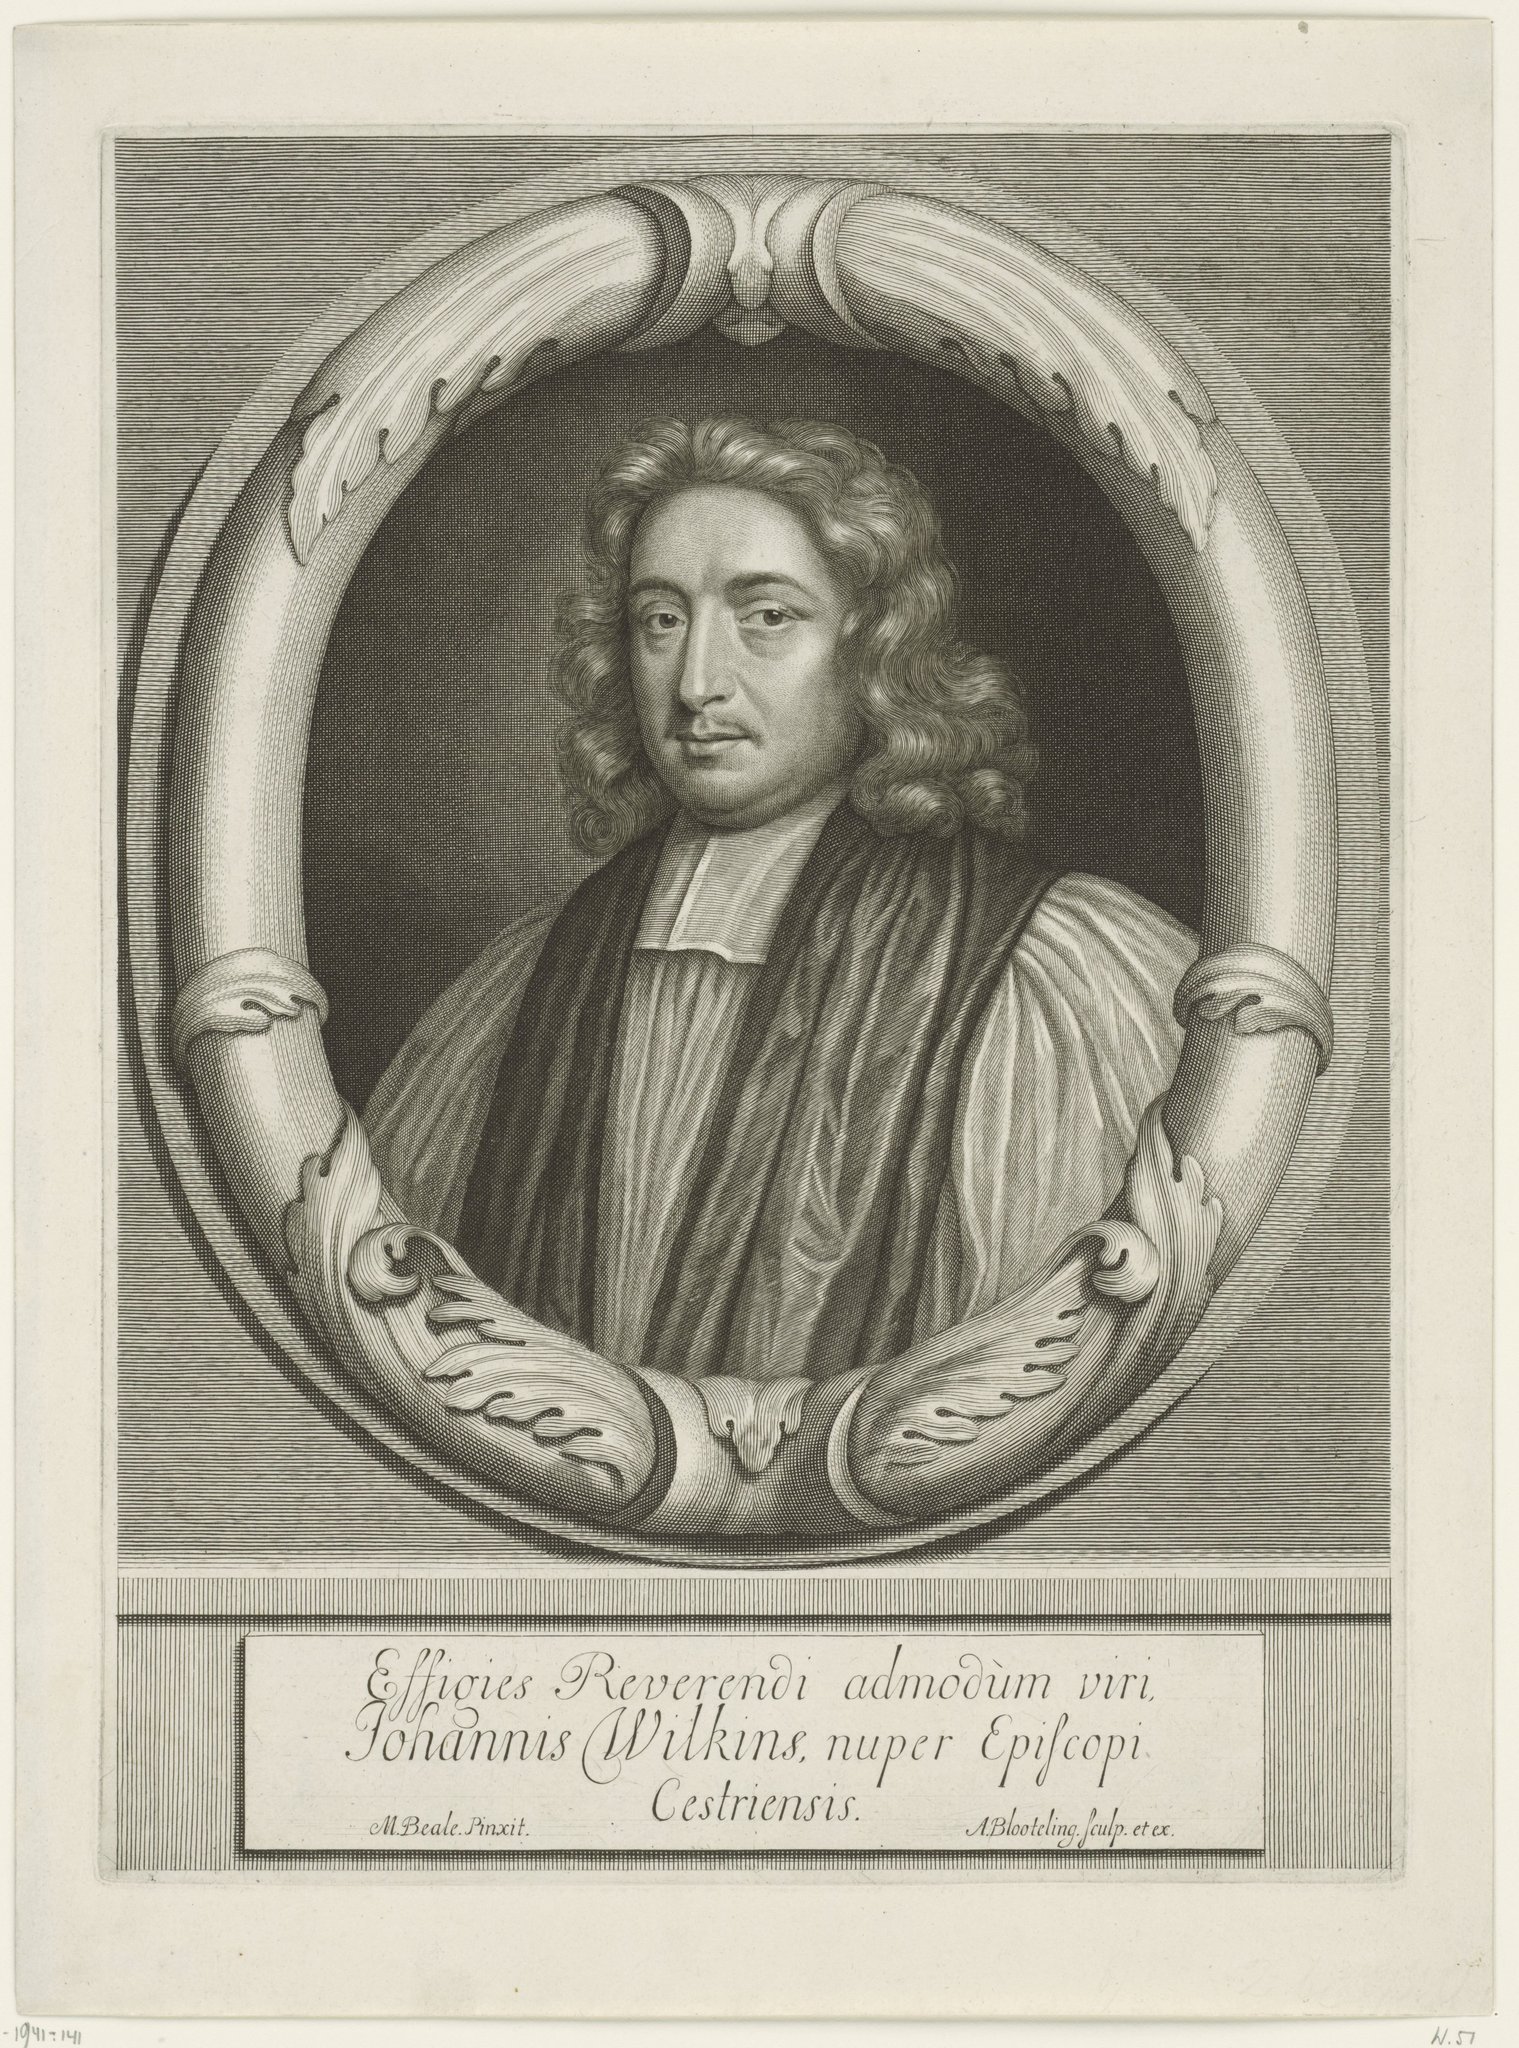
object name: print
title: Effigies Reverendi admodum viri, Johannis Wilkins, nuper Episcopi Cestriensis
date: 1672-1678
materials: paper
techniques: engraving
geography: london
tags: archbishop, bishop, etc. (roman catholic)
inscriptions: collector's mark: Lugt 2228, collector's mark: Lugt 2760